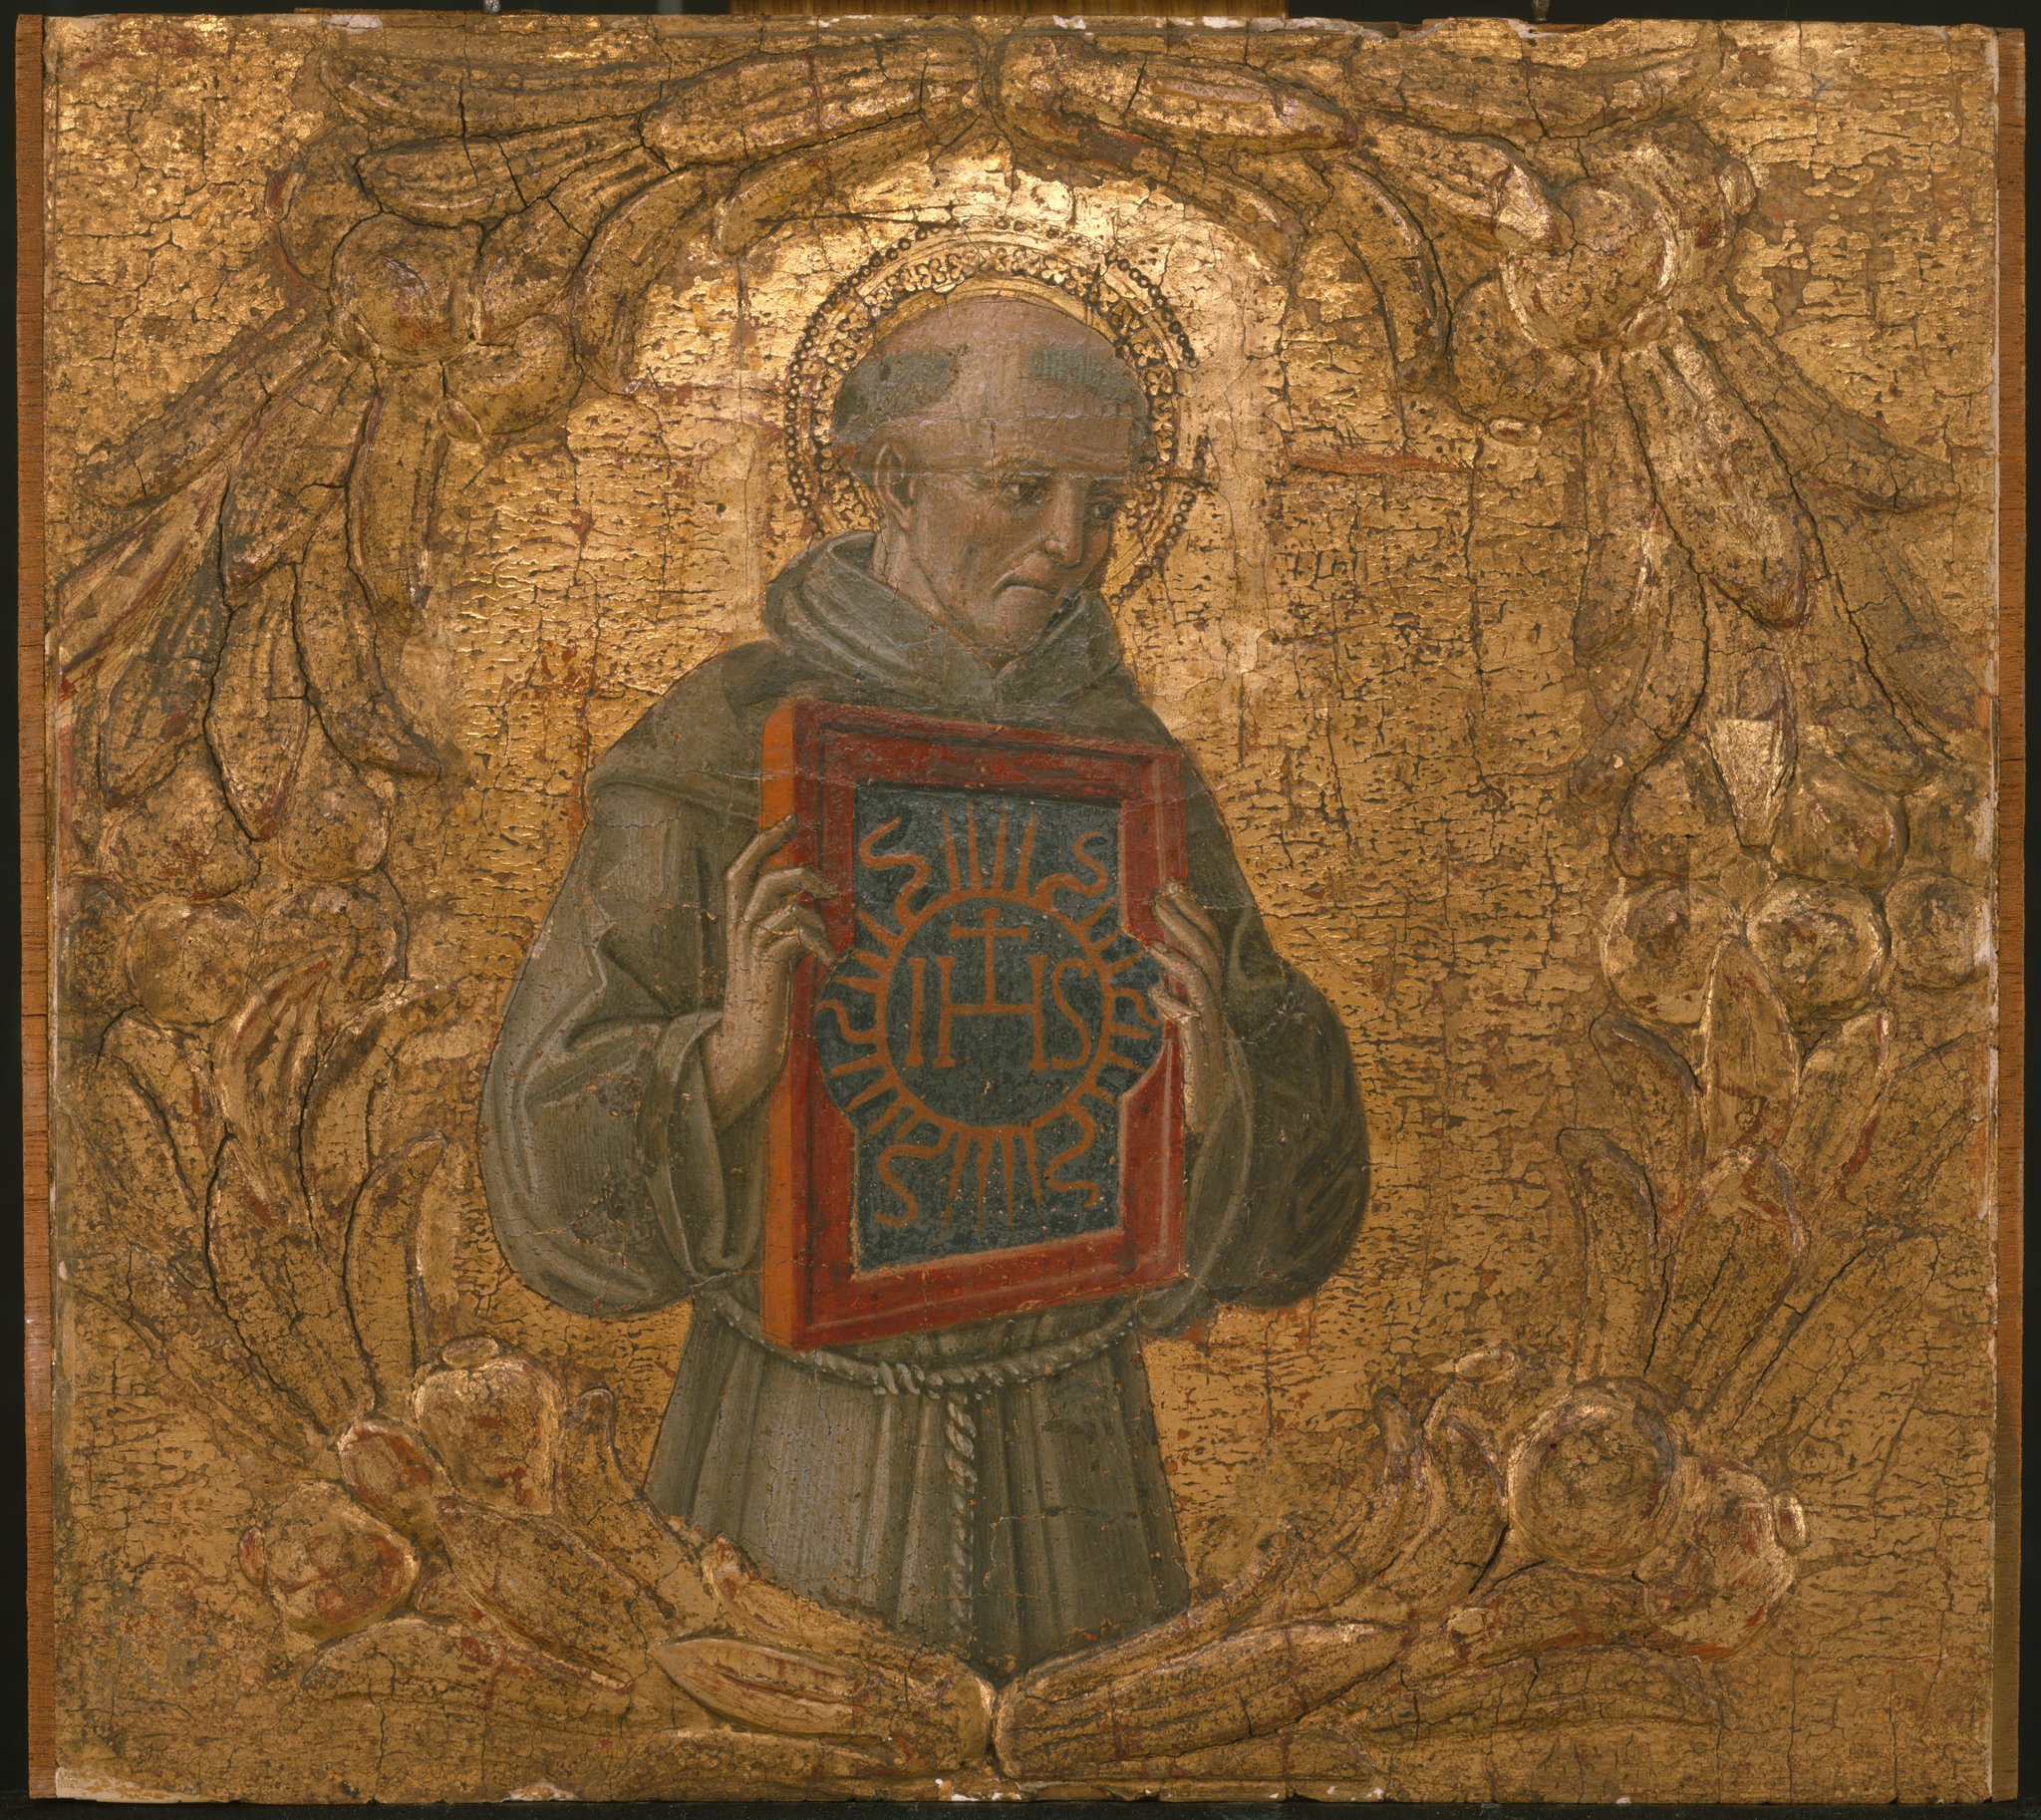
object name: painting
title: Saint Bernardino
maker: benvenuto di giovanni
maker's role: artist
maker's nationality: italian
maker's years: 1436-1518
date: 1474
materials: gold leaf, paint, wood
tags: men,saints